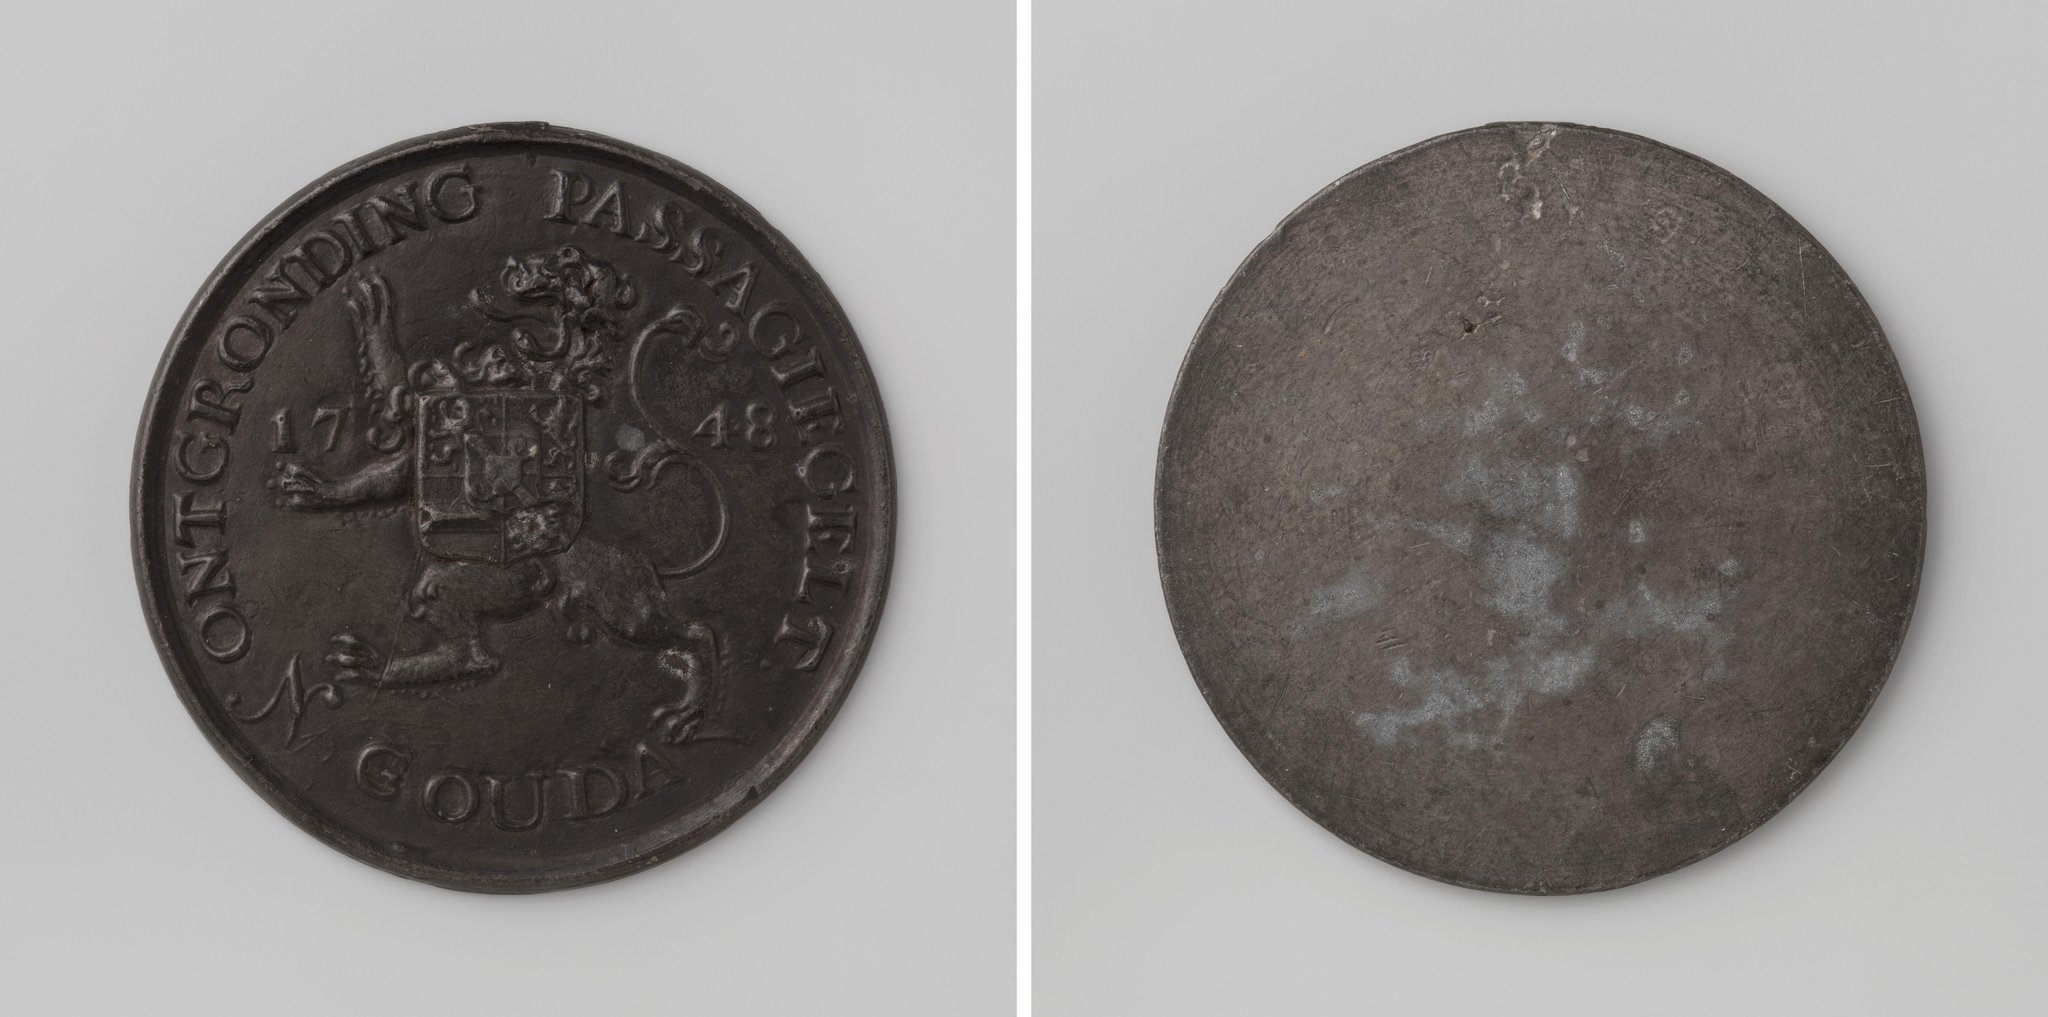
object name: ontgrondingspenning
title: Ontgronding te Gouda, penning bedoeld als bewijs voor turfdragers, -vullers of -tonners om turf in te mogen voeren uit de nieuw ontgronde venen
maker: Anonymous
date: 1748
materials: lead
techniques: casting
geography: gouda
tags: gouda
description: Eenzijdige loden penning. Voorzijde: staande leeuw met wapenschild op borst tussen jaartal binnen omschrift. Keerzijde: blanco.